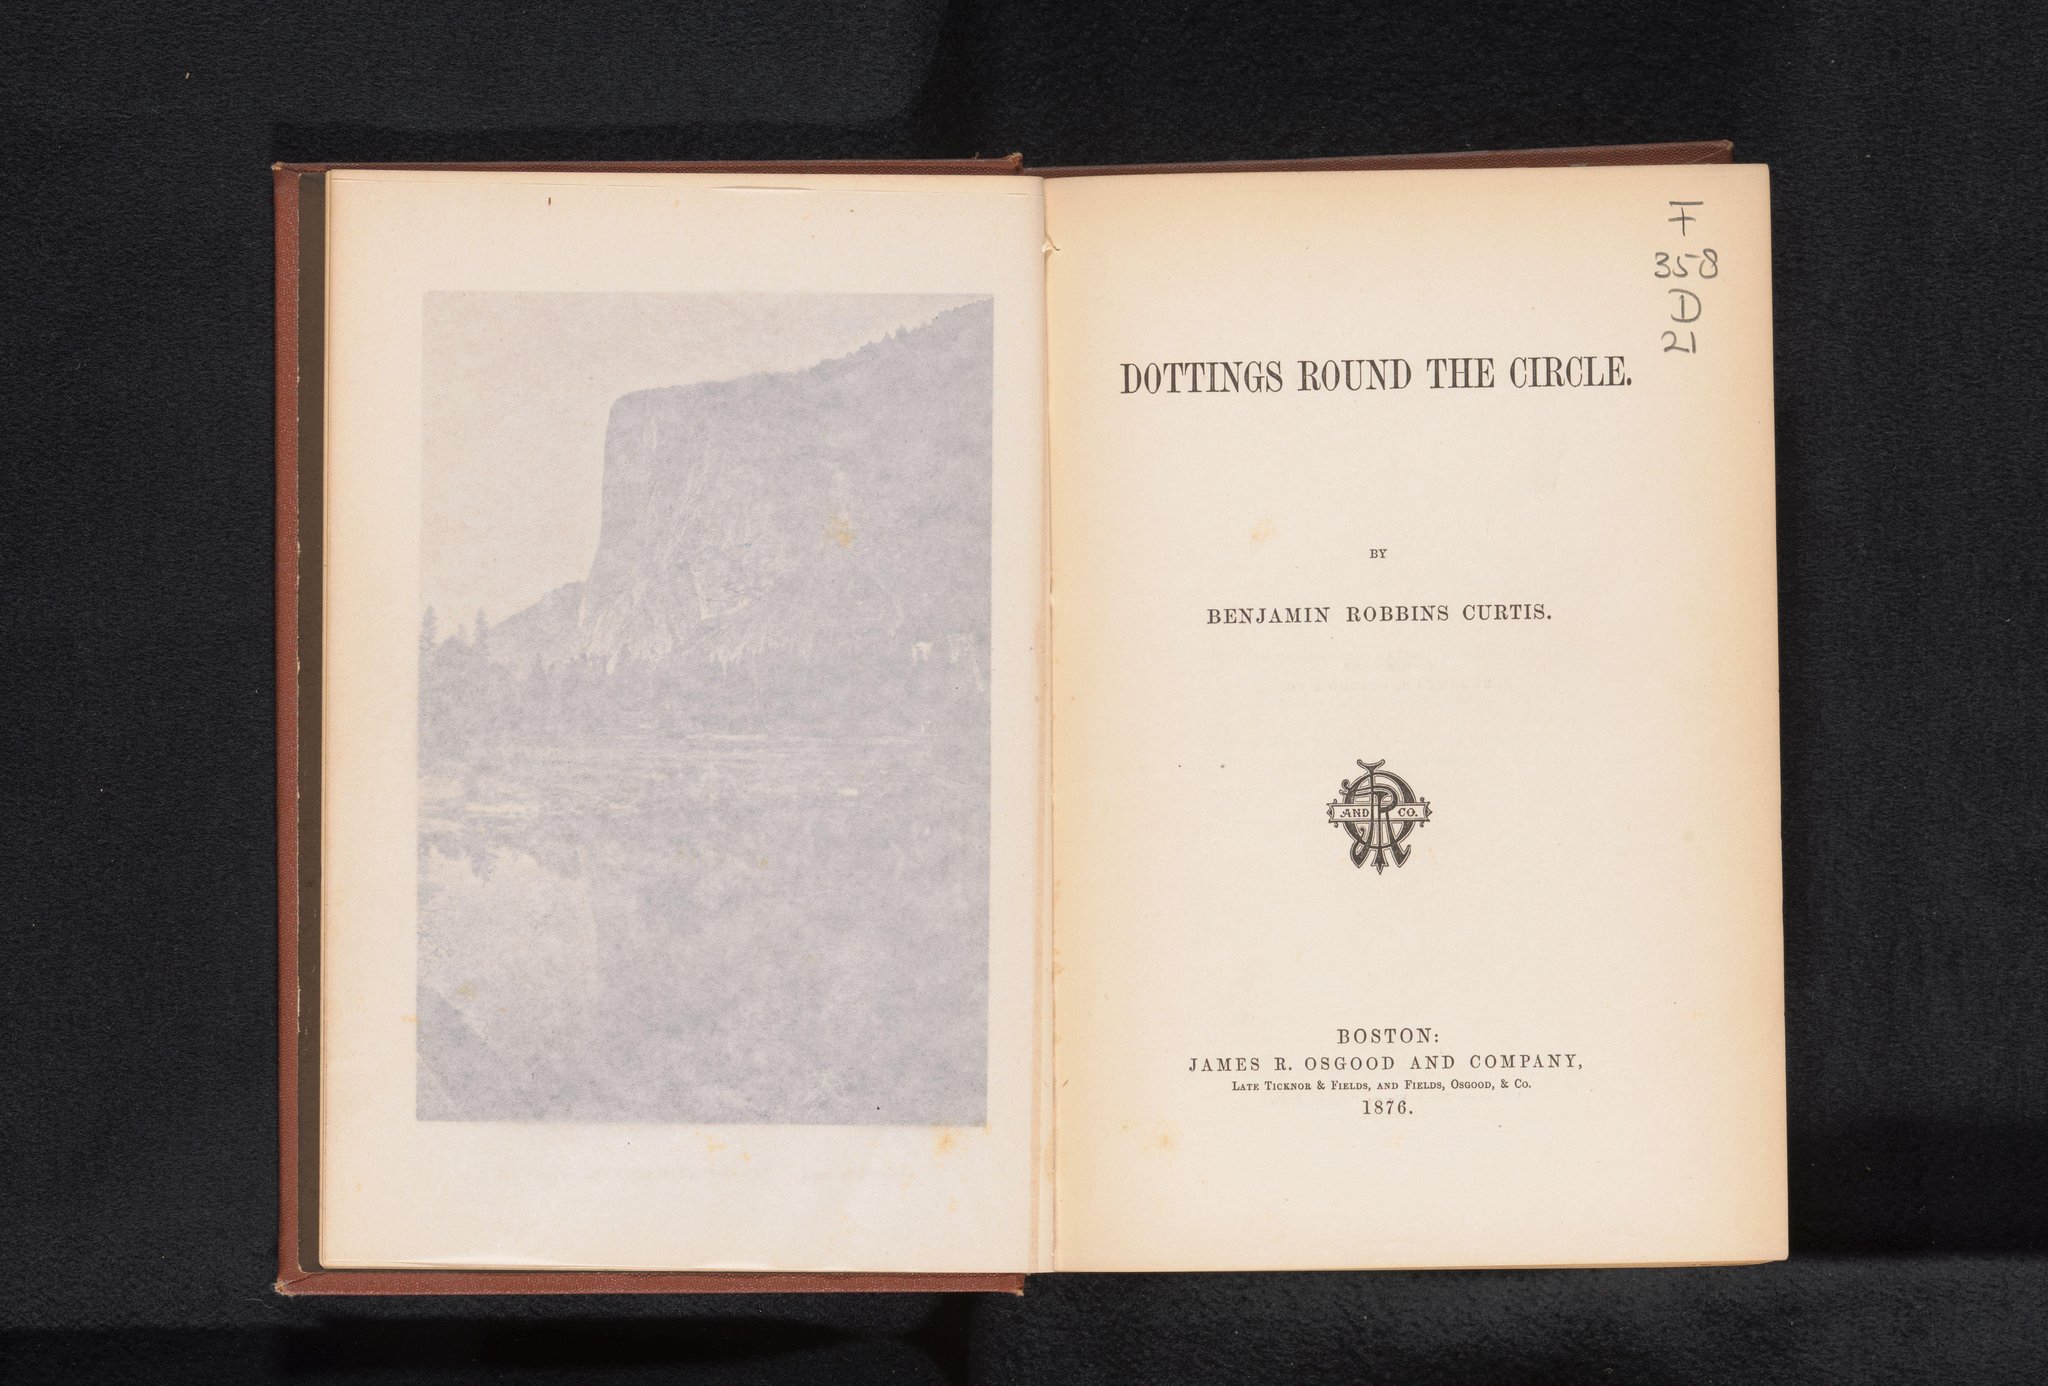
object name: book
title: Dottings round the circle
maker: benjamin robbins curtis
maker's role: schrijver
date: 1876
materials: cardboard, linen, paper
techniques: photograph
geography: boston